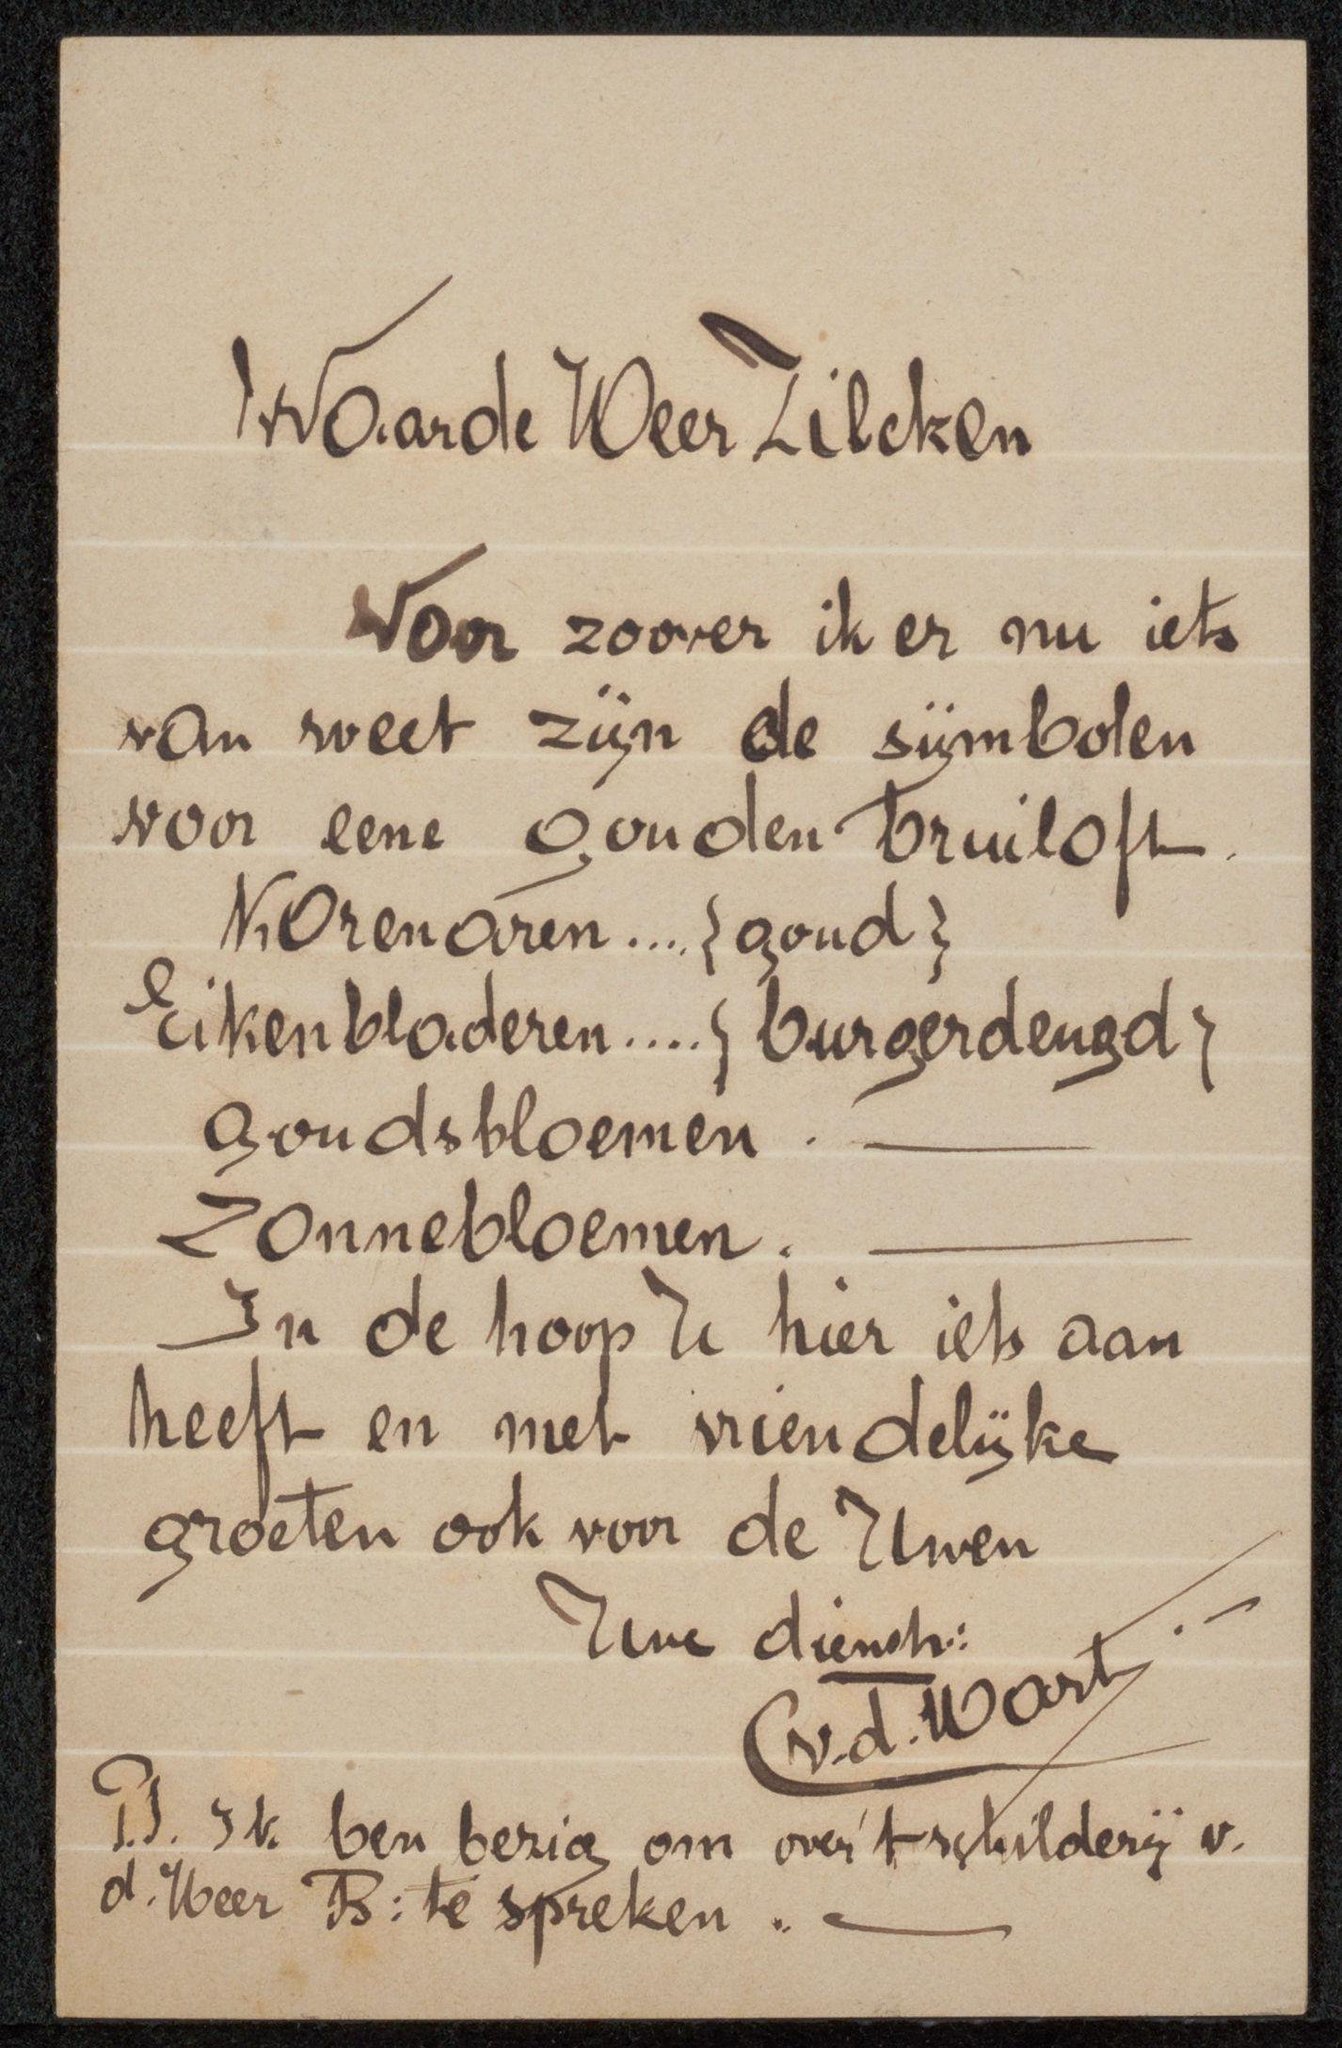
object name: letter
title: Brief aan Philip Zilcken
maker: cornelia van der hart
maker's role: print maker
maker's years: 1851-1940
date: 1861-1940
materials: ink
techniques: pen, writing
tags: the hague, painter, draughtsman, philip zilcken, painting (including book-illumination, miniature-painting)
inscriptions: collector's mark: ‘RPK’